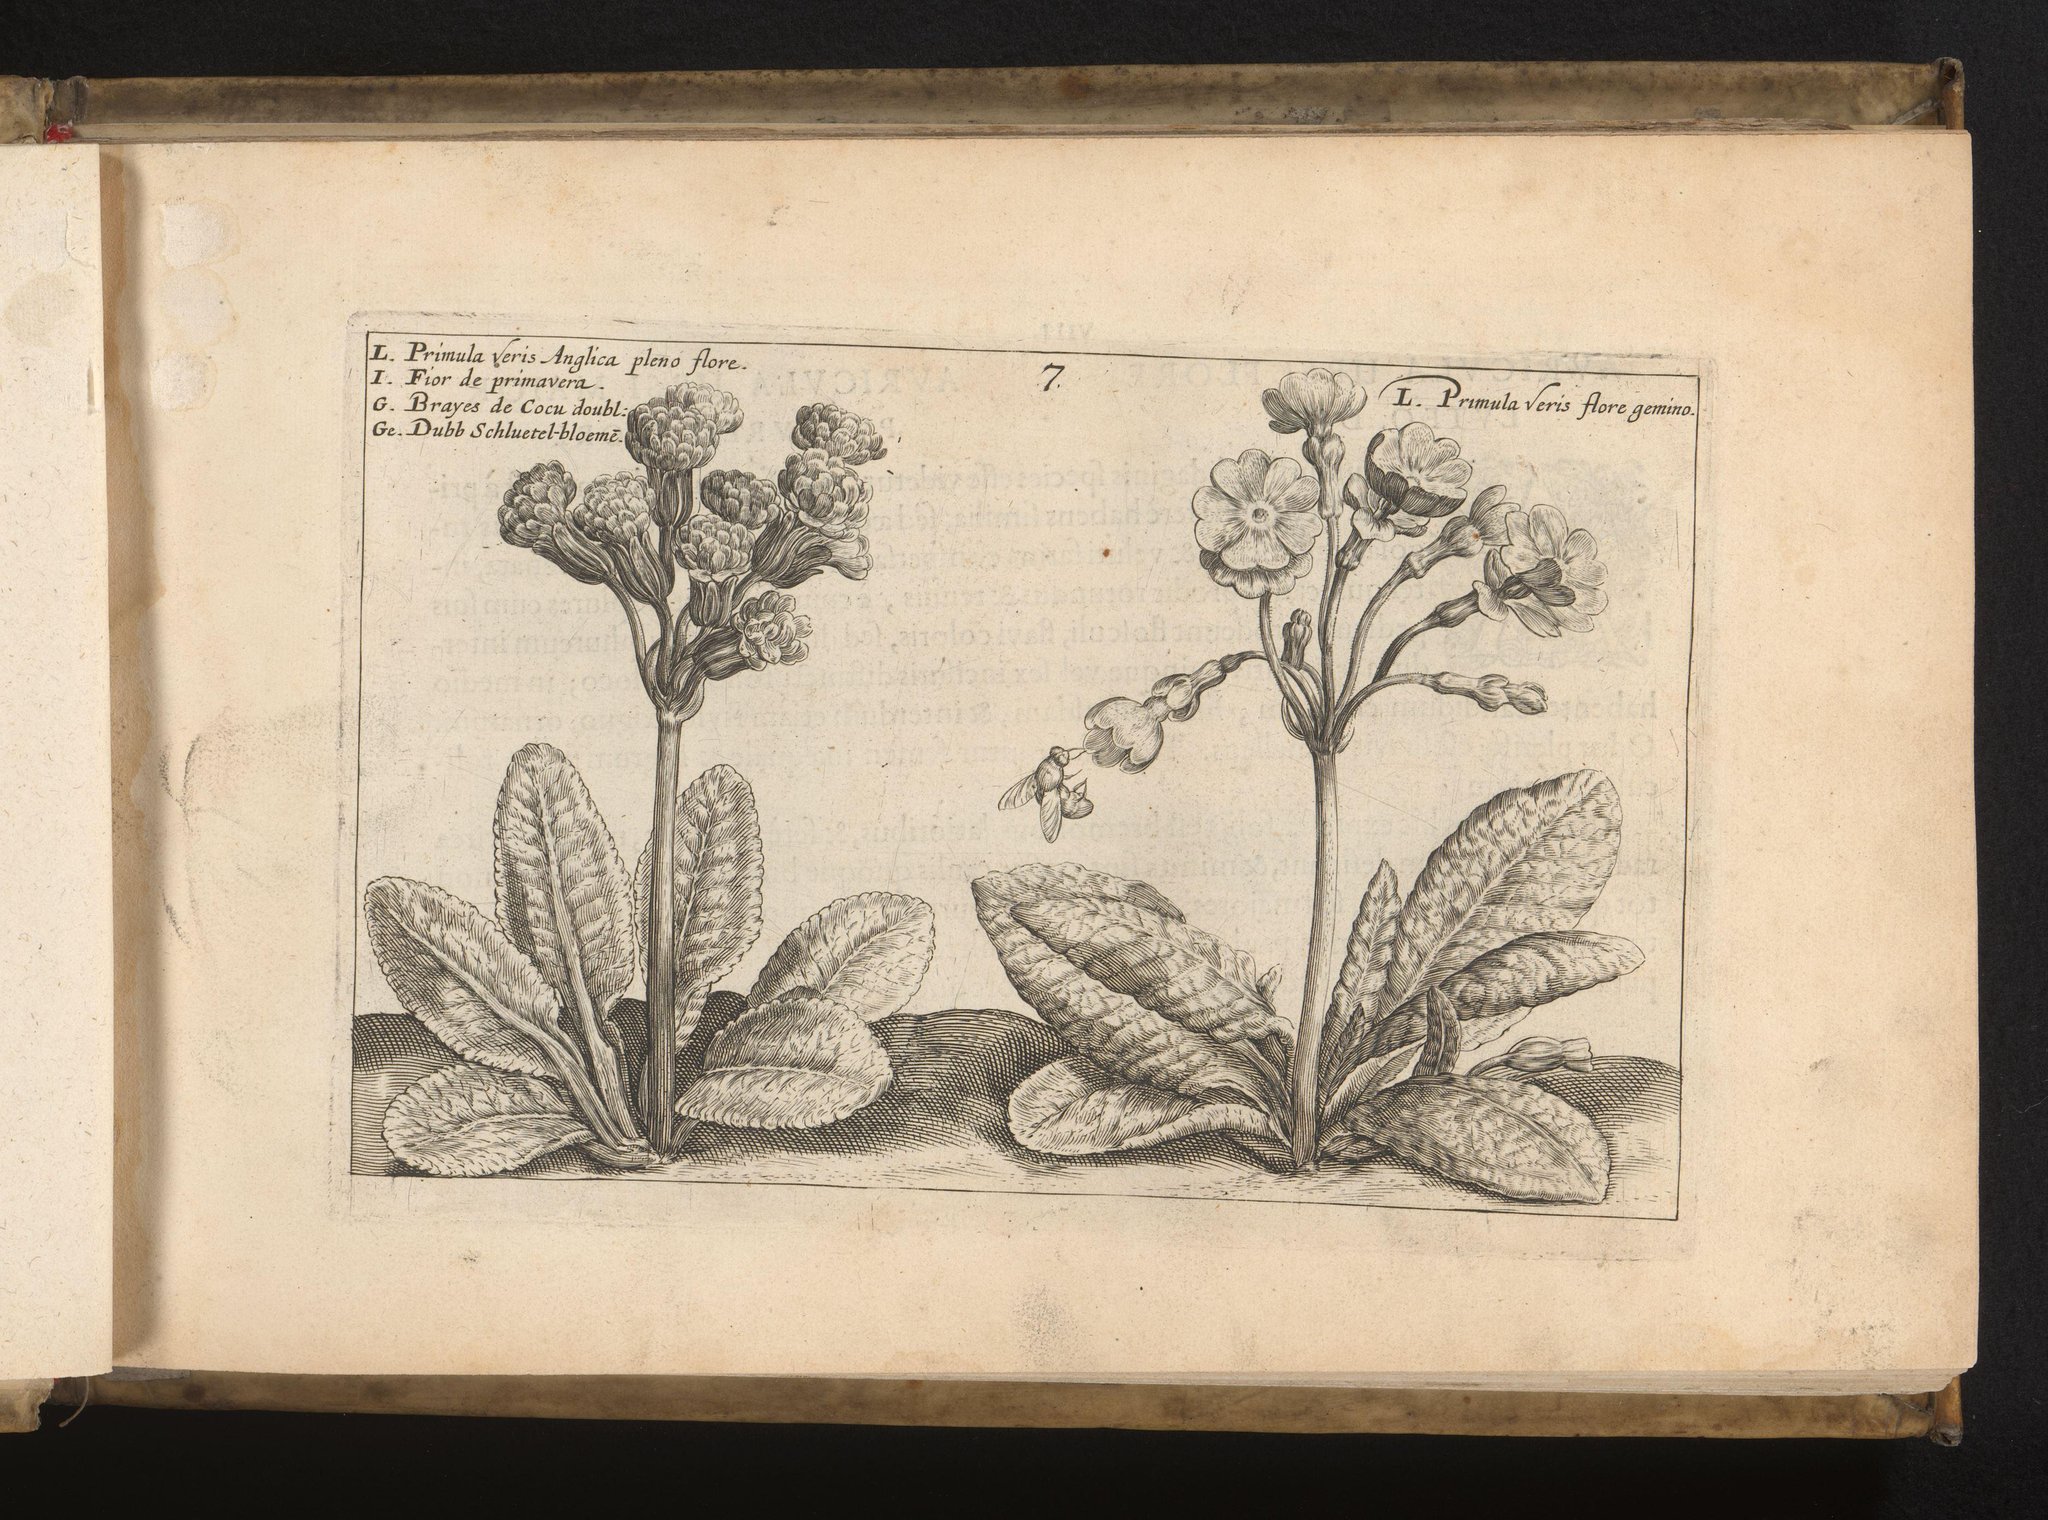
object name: book illustration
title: Gulden sleutelbloem en een variant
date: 1617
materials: paper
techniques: engraving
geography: utrecht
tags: flowers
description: Prent uit: Passe, Crispijn van de (II). Hortus floridus in quo rariorum & minus vulgarium florum icones ad vivam veramque formam. Arnhem: Johannes Janssonius, 1617.